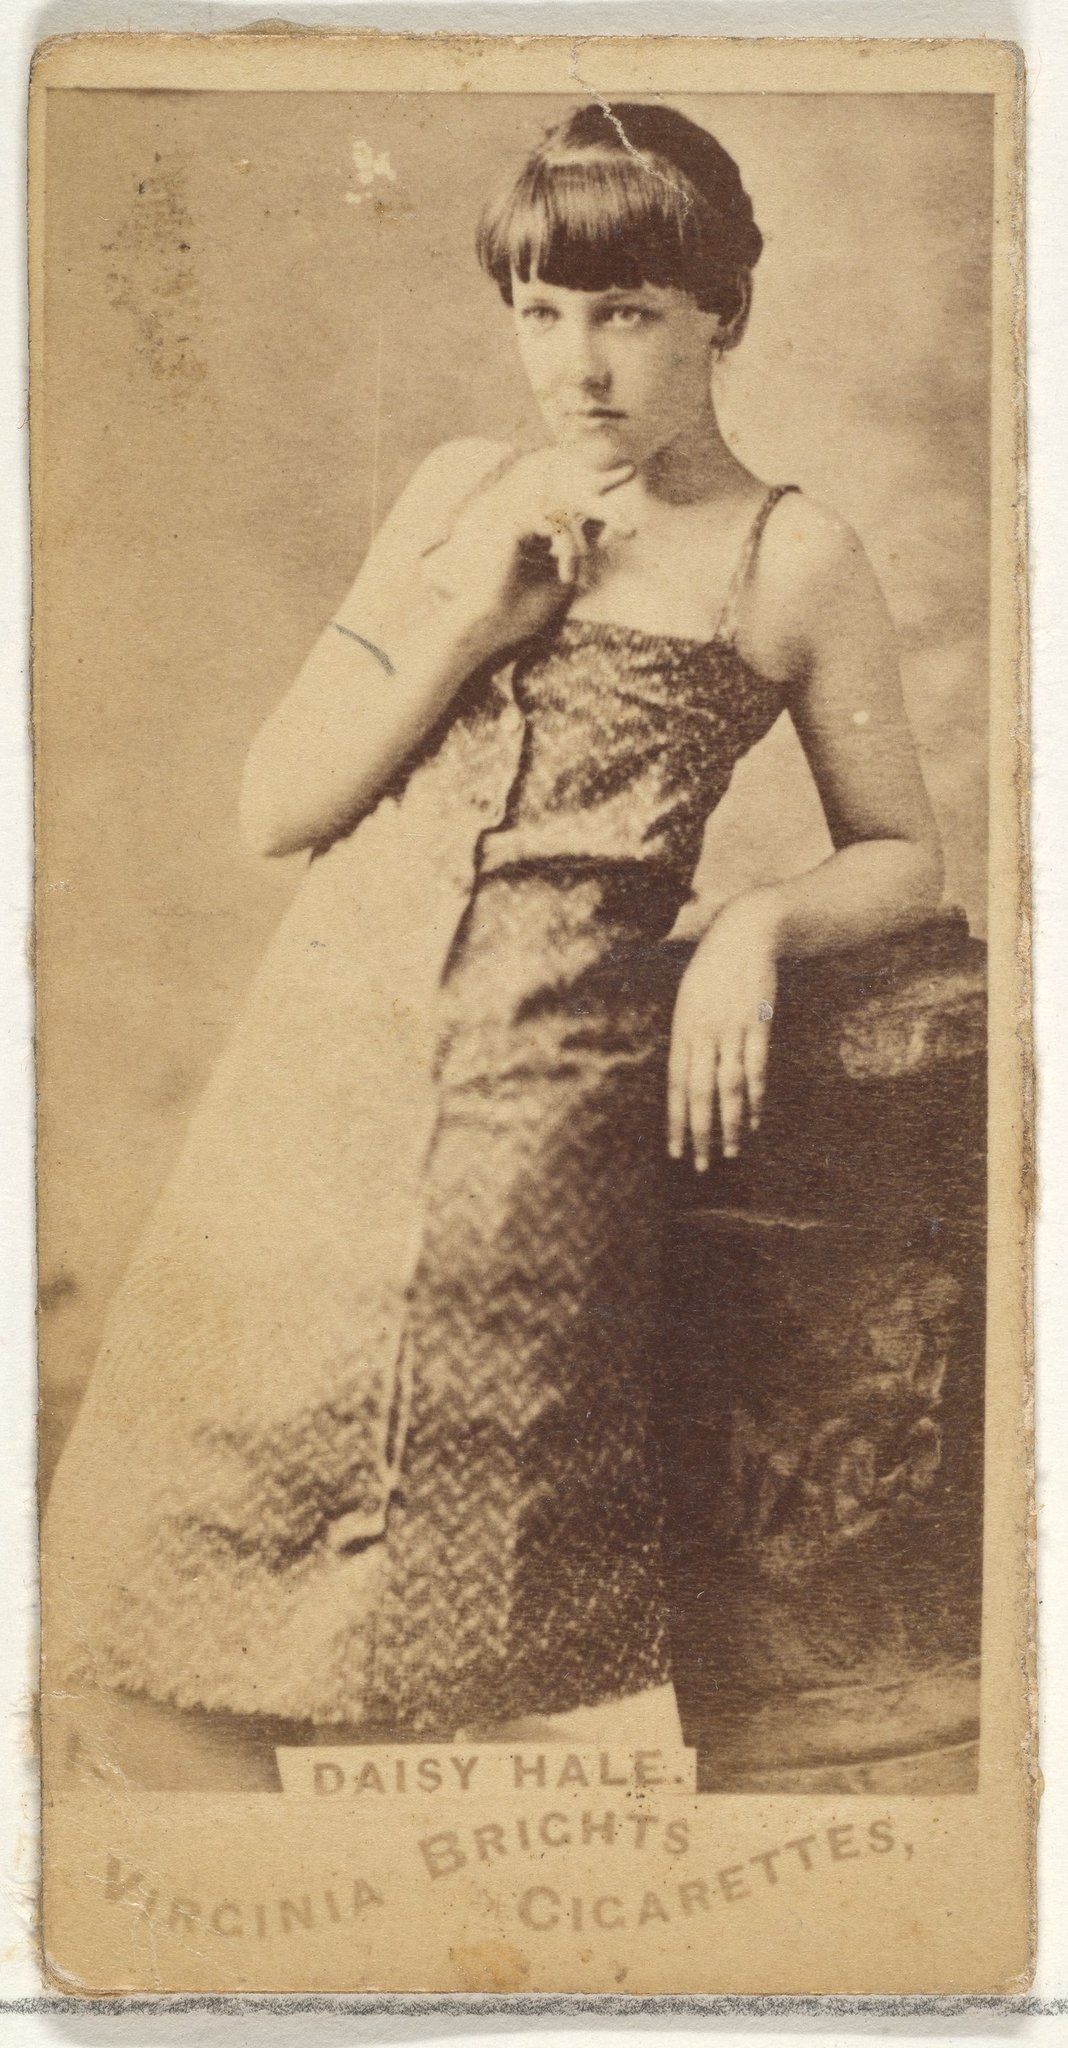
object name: photograph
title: Daisy Hale, from the Actors and Actresses series (N45, Type 1) for Virginia Brights Cigarettes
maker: allen & ginter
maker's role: publisher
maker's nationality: american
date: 1888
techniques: albumen silver print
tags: portraits,women,actresses